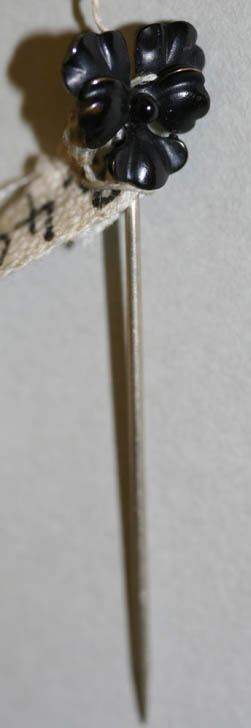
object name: pin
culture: american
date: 1893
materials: enamel